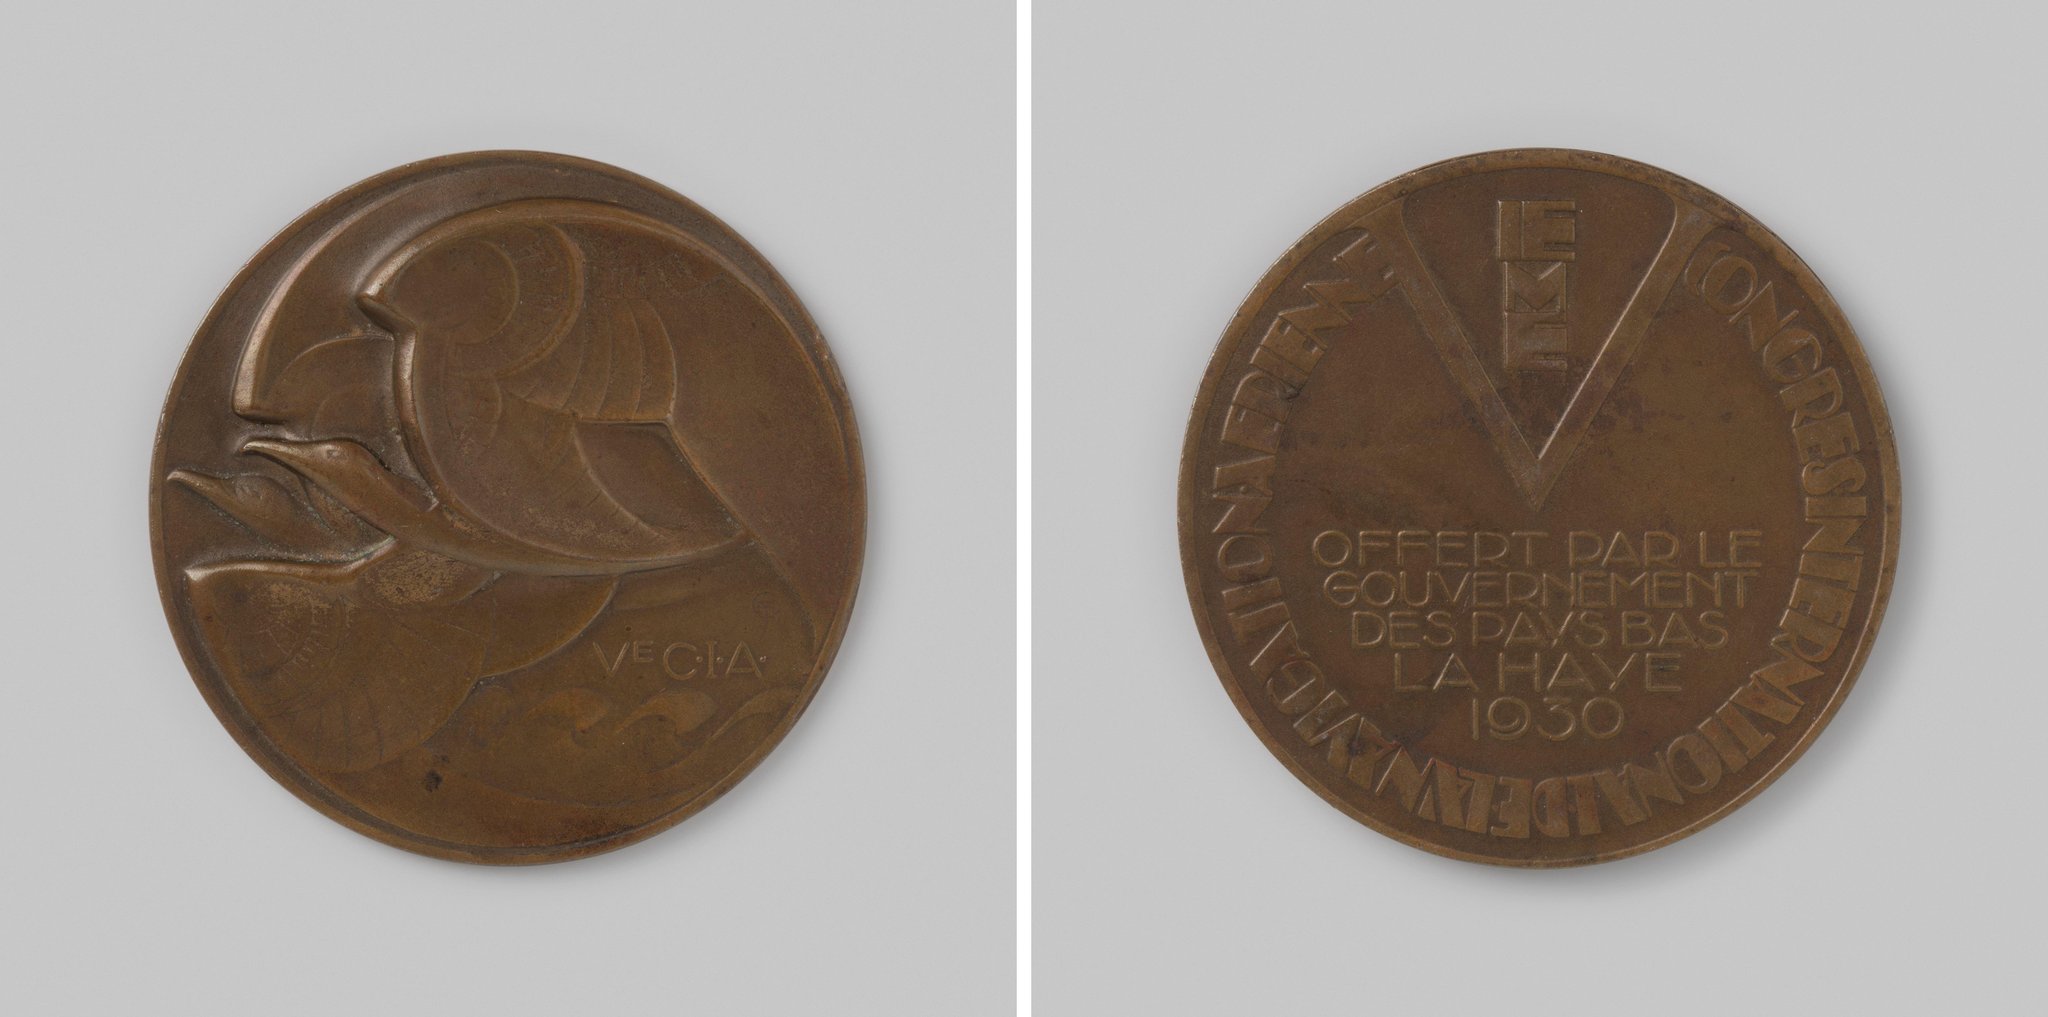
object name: medal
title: Vijfde Internationaal Luchtvaartcongres Den Haag 1930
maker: chris van der hoef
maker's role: ceramicist, draughtsman, sculptor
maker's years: 1875-1933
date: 1930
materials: bronze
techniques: striking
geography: voorschoten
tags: the hague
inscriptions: inscription: ‘Ve C.I.A.’, inscription: ‘V IEME’, circumscription: ‘CONGRES INTERNATIONAL DE LA NAVIGATION AERIENNE’, inscription: ‘OFFERT PAR LE GOUVERNEMENT DES PAYS BAS LA HAYE 1930’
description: Bronzen penning. Voorzijde: Twee naast elkaar, naar links vliegende vogels (adelaars), met rechtsonder opschrift. Keerzijde: grote V aan bovenzijde, waarbinnen "IEME", doorgaand in omschrift, in onderste helft veld een opschrift.